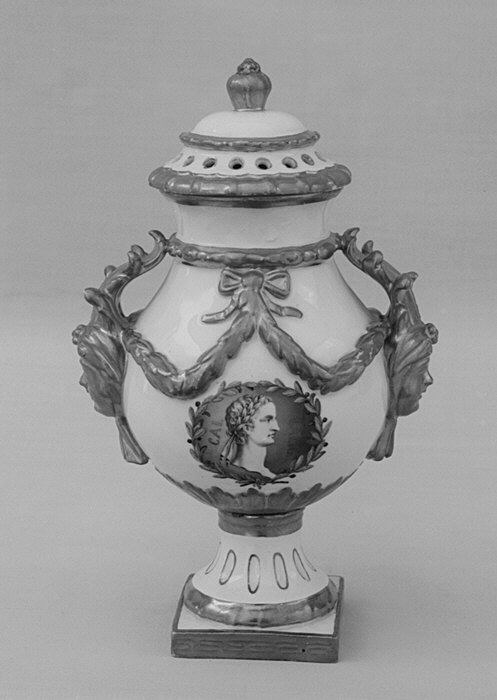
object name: vase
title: Vase (part of a garniture)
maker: fürstenberg porcelain manufactory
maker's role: manufactory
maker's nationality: german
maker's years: 1747-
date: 1780-1790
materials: hard paste porcelain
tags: profiles